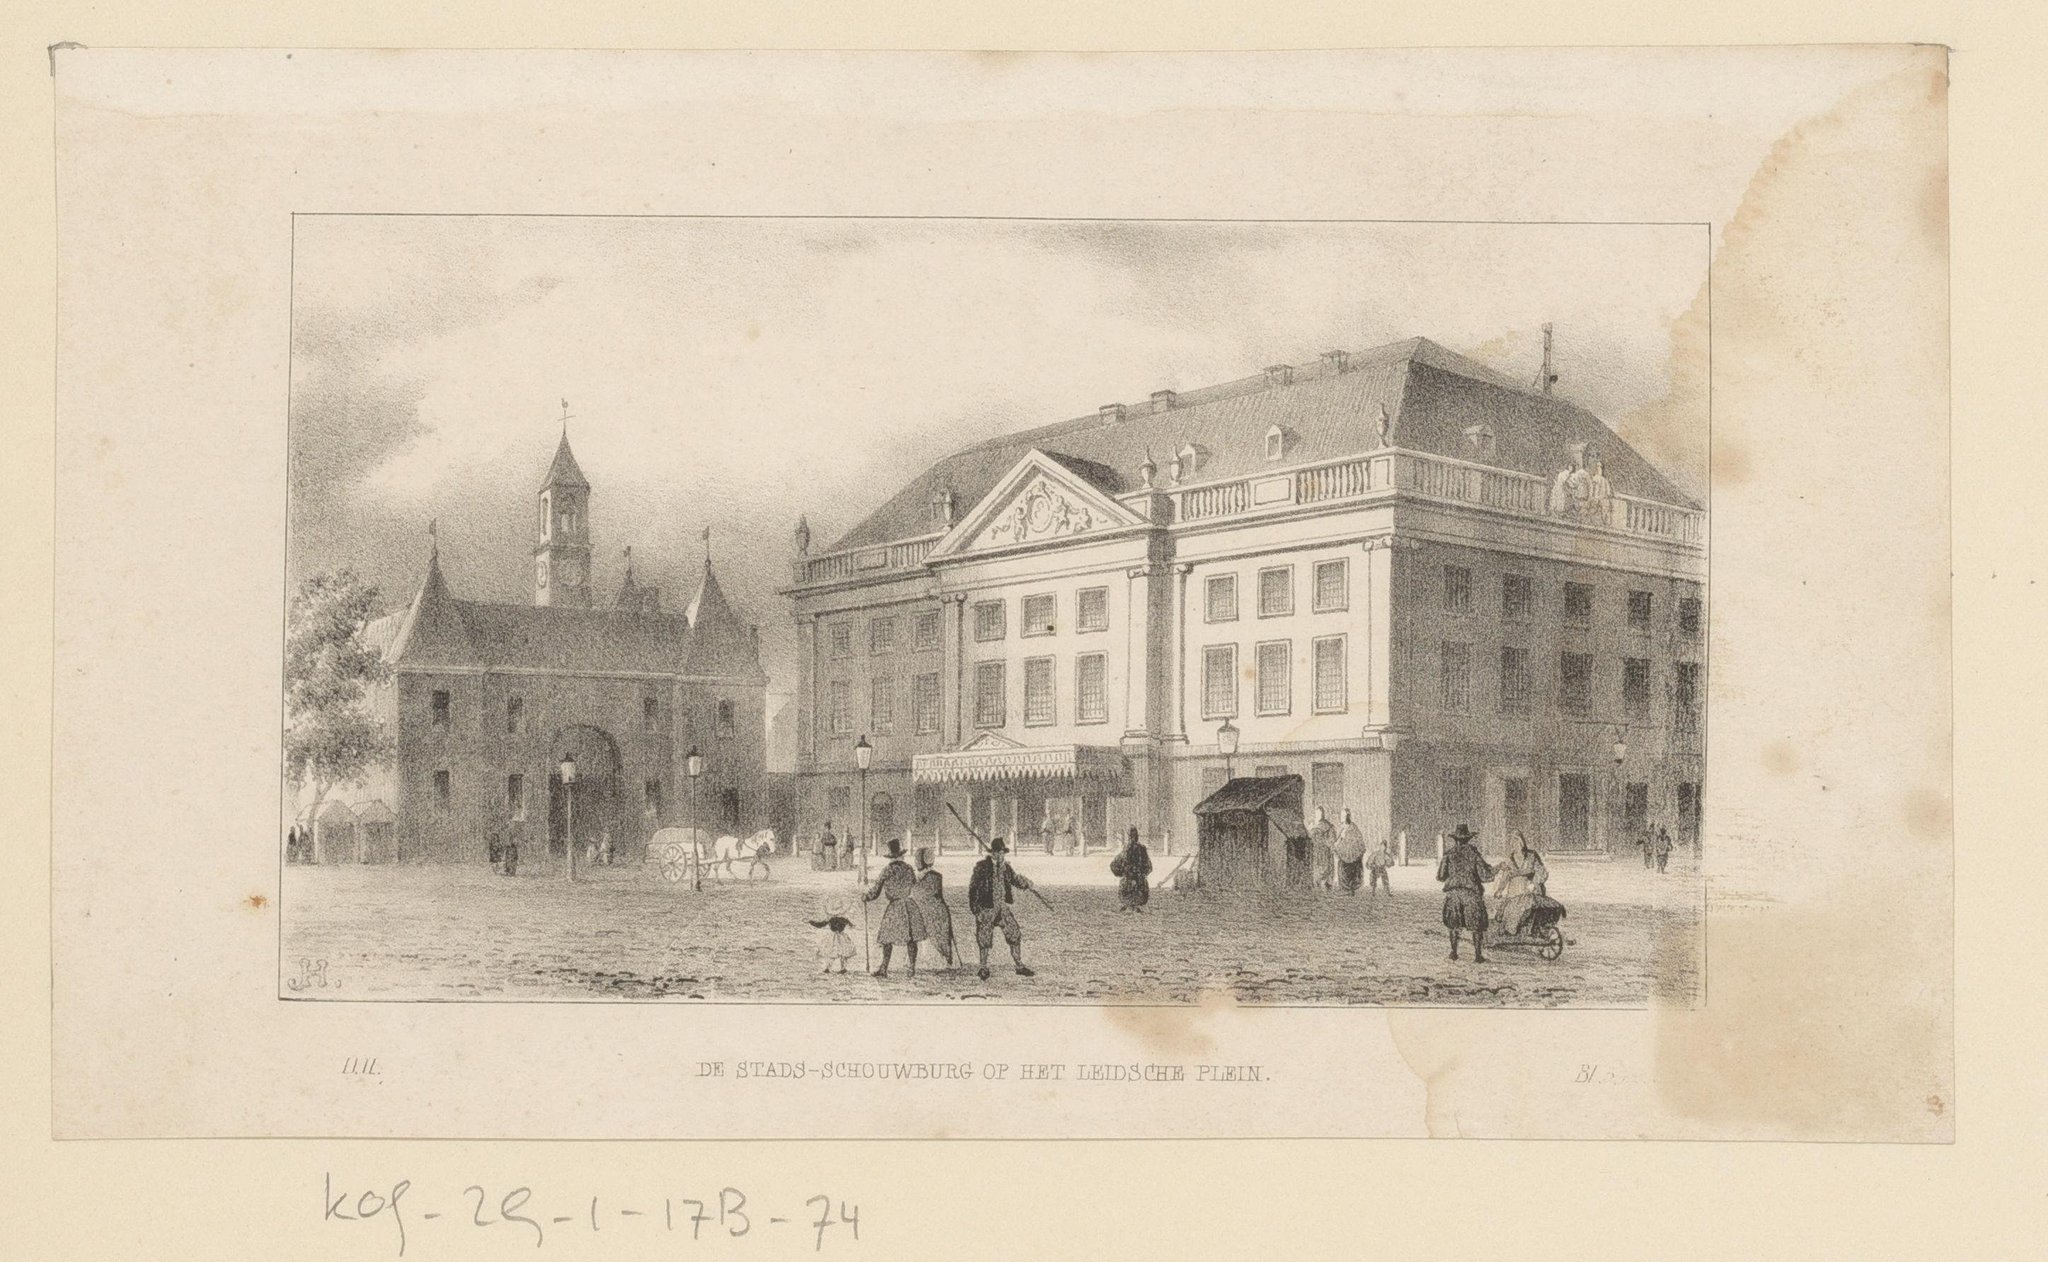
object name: print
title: De stads-schouwburg op het Leidsche Plein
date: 1845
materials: paper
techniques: lithograph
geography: amsterdam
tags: theatre, theatrical performance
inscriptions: collector's mark: Lugt 1641, stamp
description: Prent uit: Vijver, Cornelis van der. Geschiedkundige Beschrijving der Stad Amsterdam (...). Amsterdam: Gebroeders Diederichs, 1845.